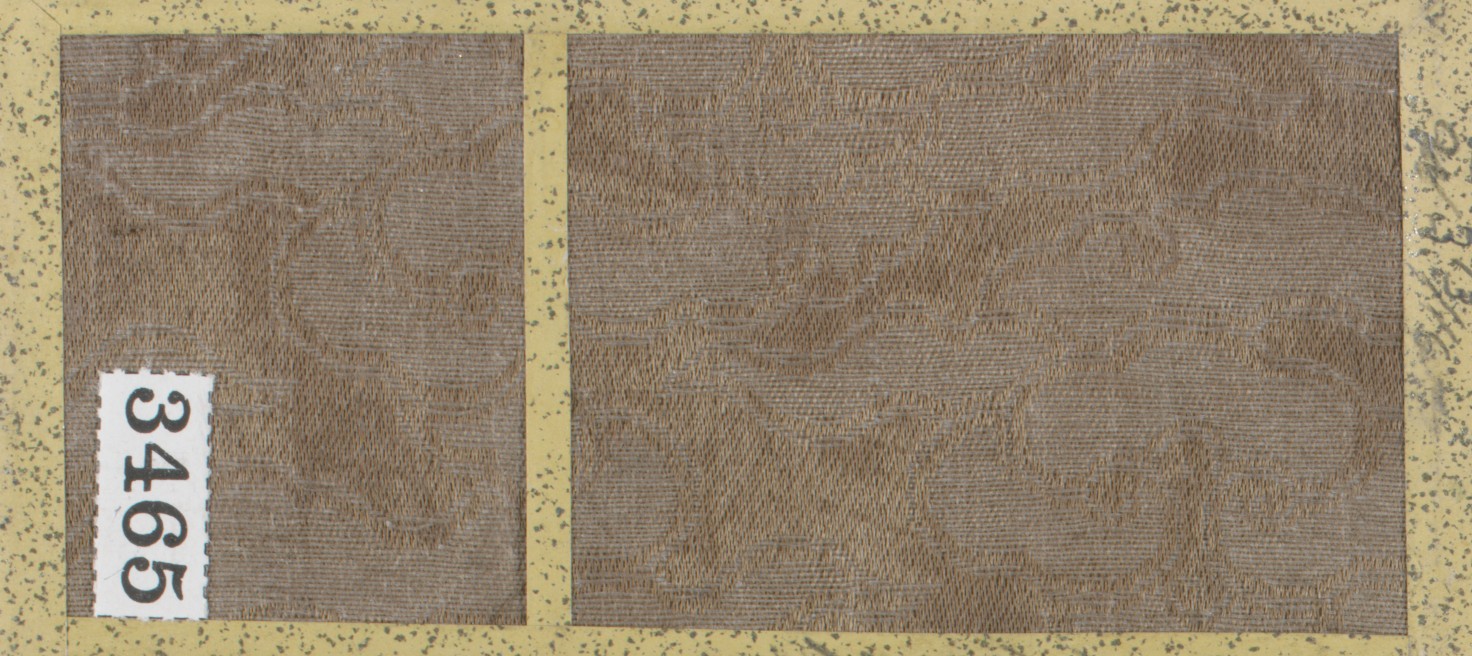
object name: sample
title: Textile Sample from Sample Book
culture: japanese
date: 1801-1900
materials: silk